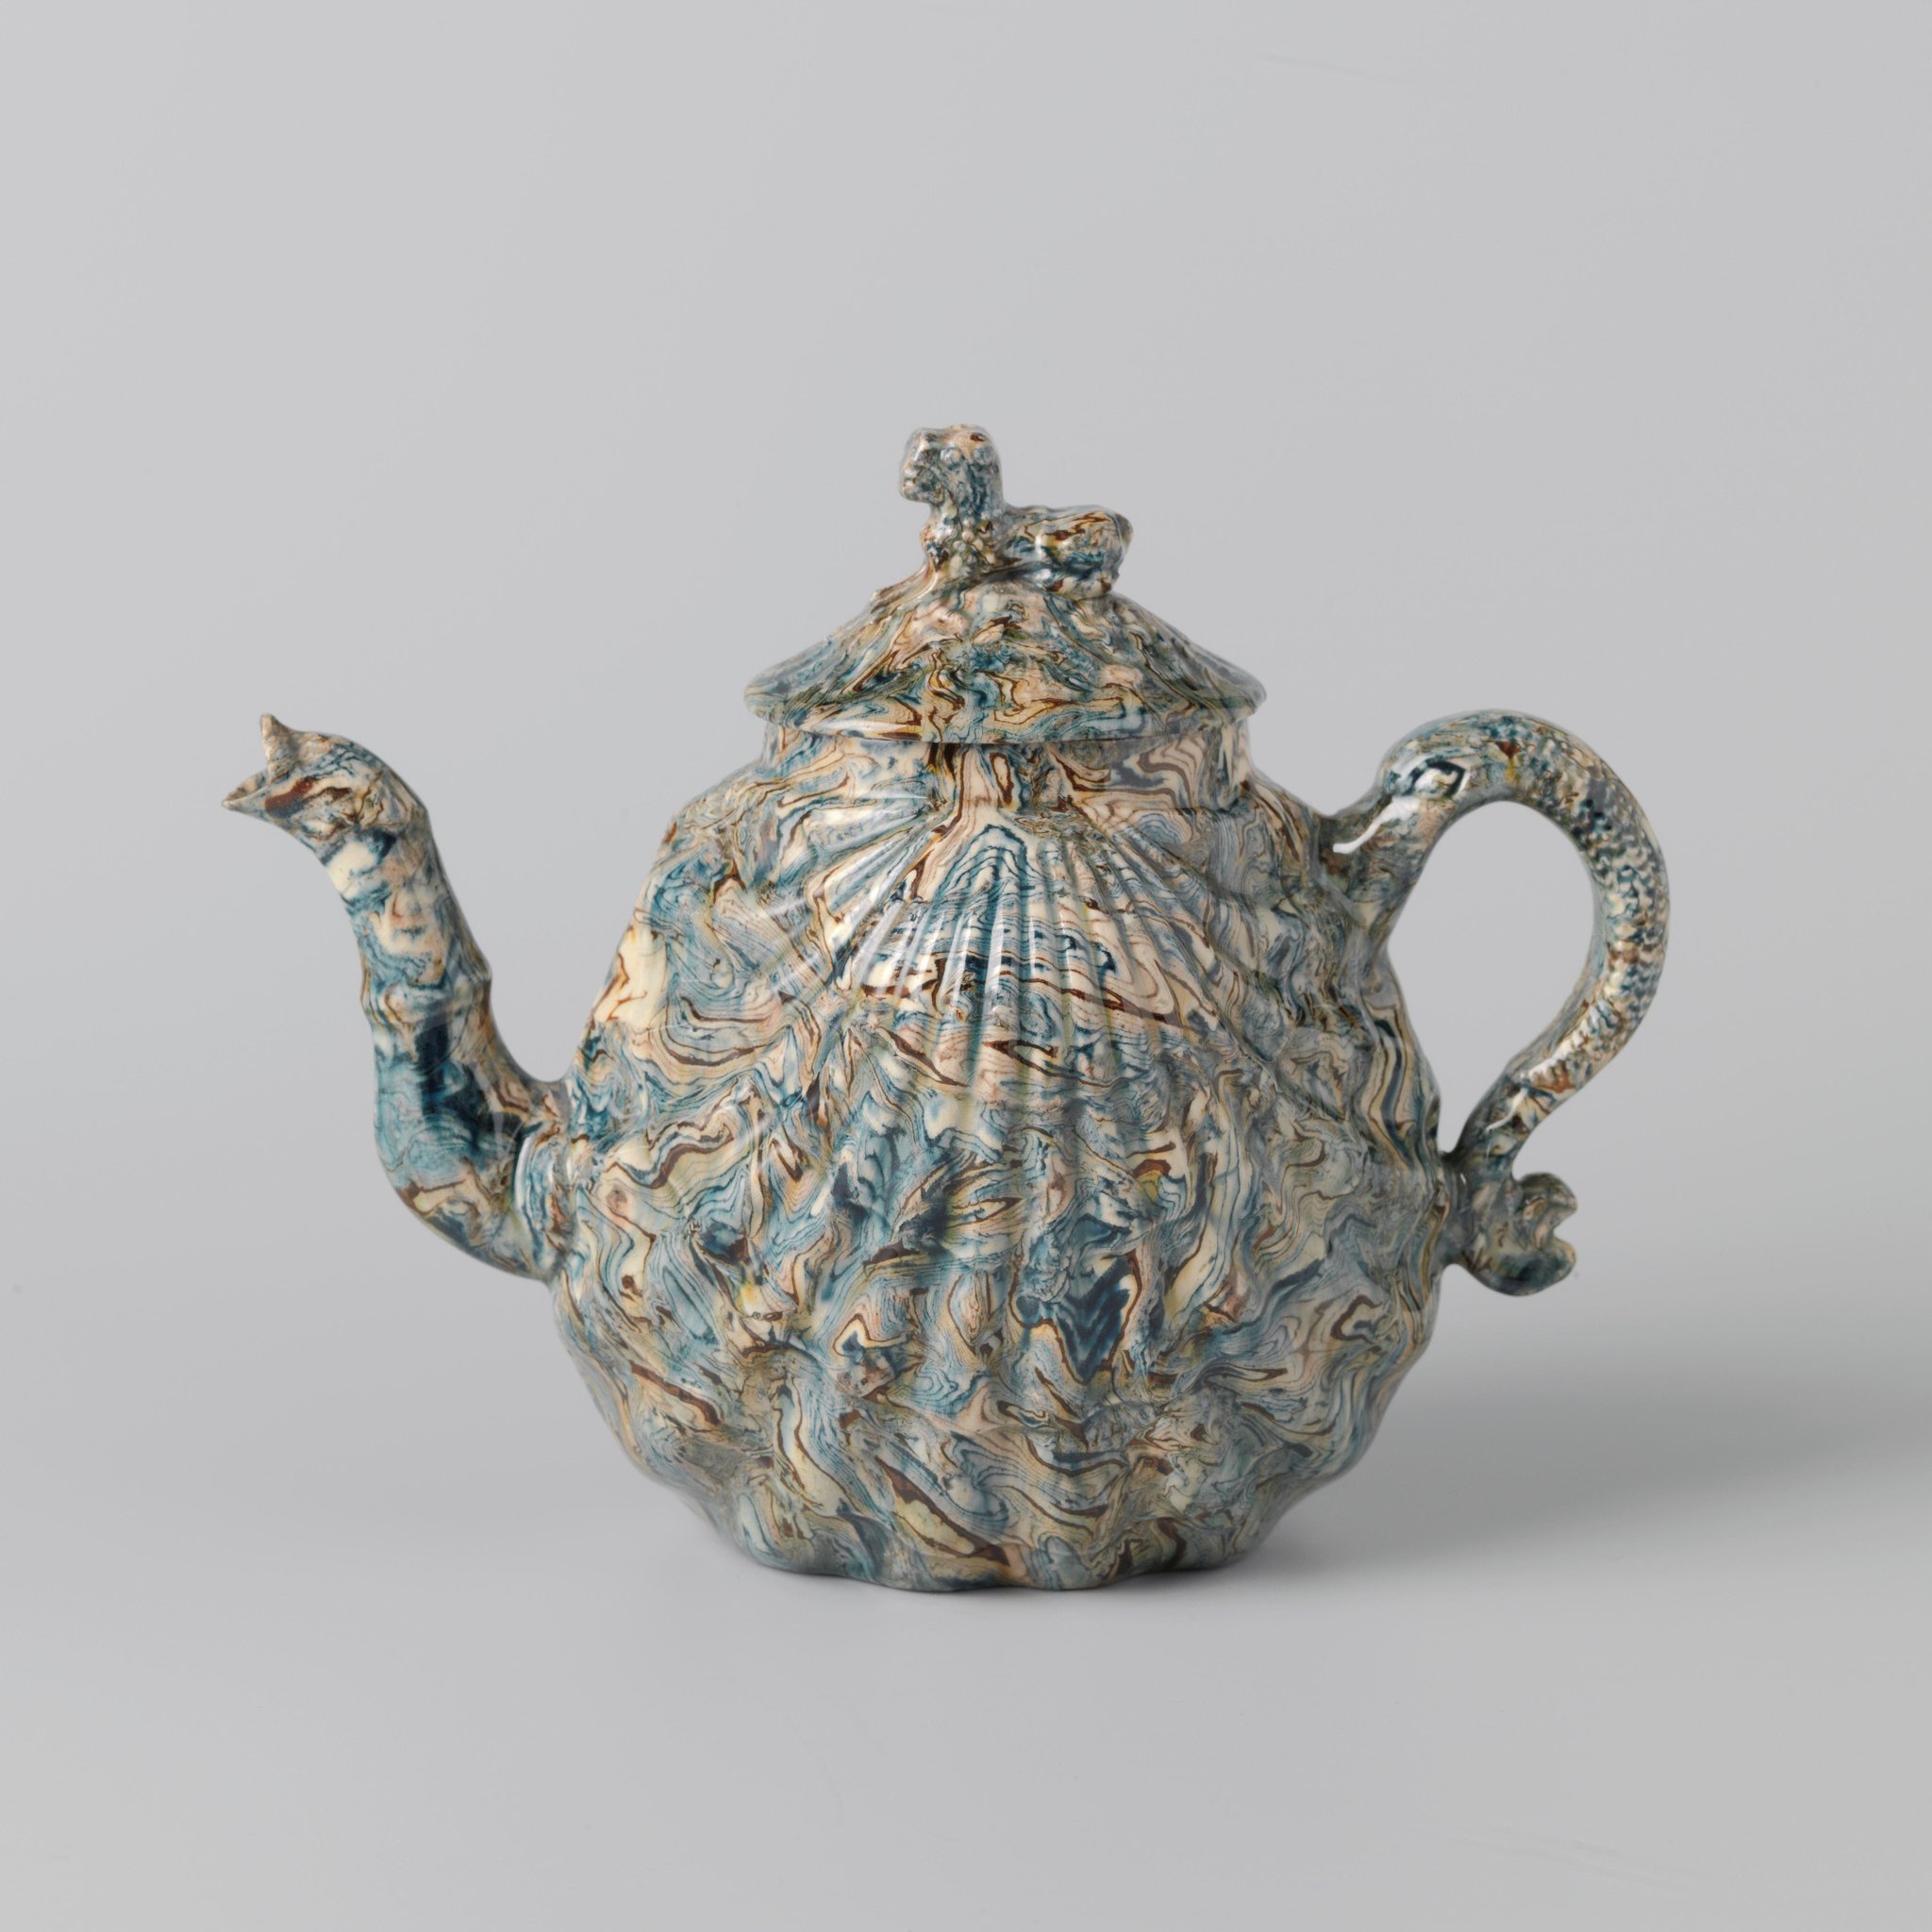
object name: teapot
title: Theepot van hardgebakken aardewerk; Staffordshire (zgn. Whieldon, agate ware).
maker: Anonymous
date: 1750-1760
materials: earthenware, glaze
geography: england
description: Theepot van hardgebakken aardewerk. De beide zijden zijn gevormd als een schelp. De tuit heeft de vorm van een dierenkop. Het oor heeft het uiterlijk van een slang. Het glazuur is gemarmerd in de kleuren blauw, groen, geel en bruin.